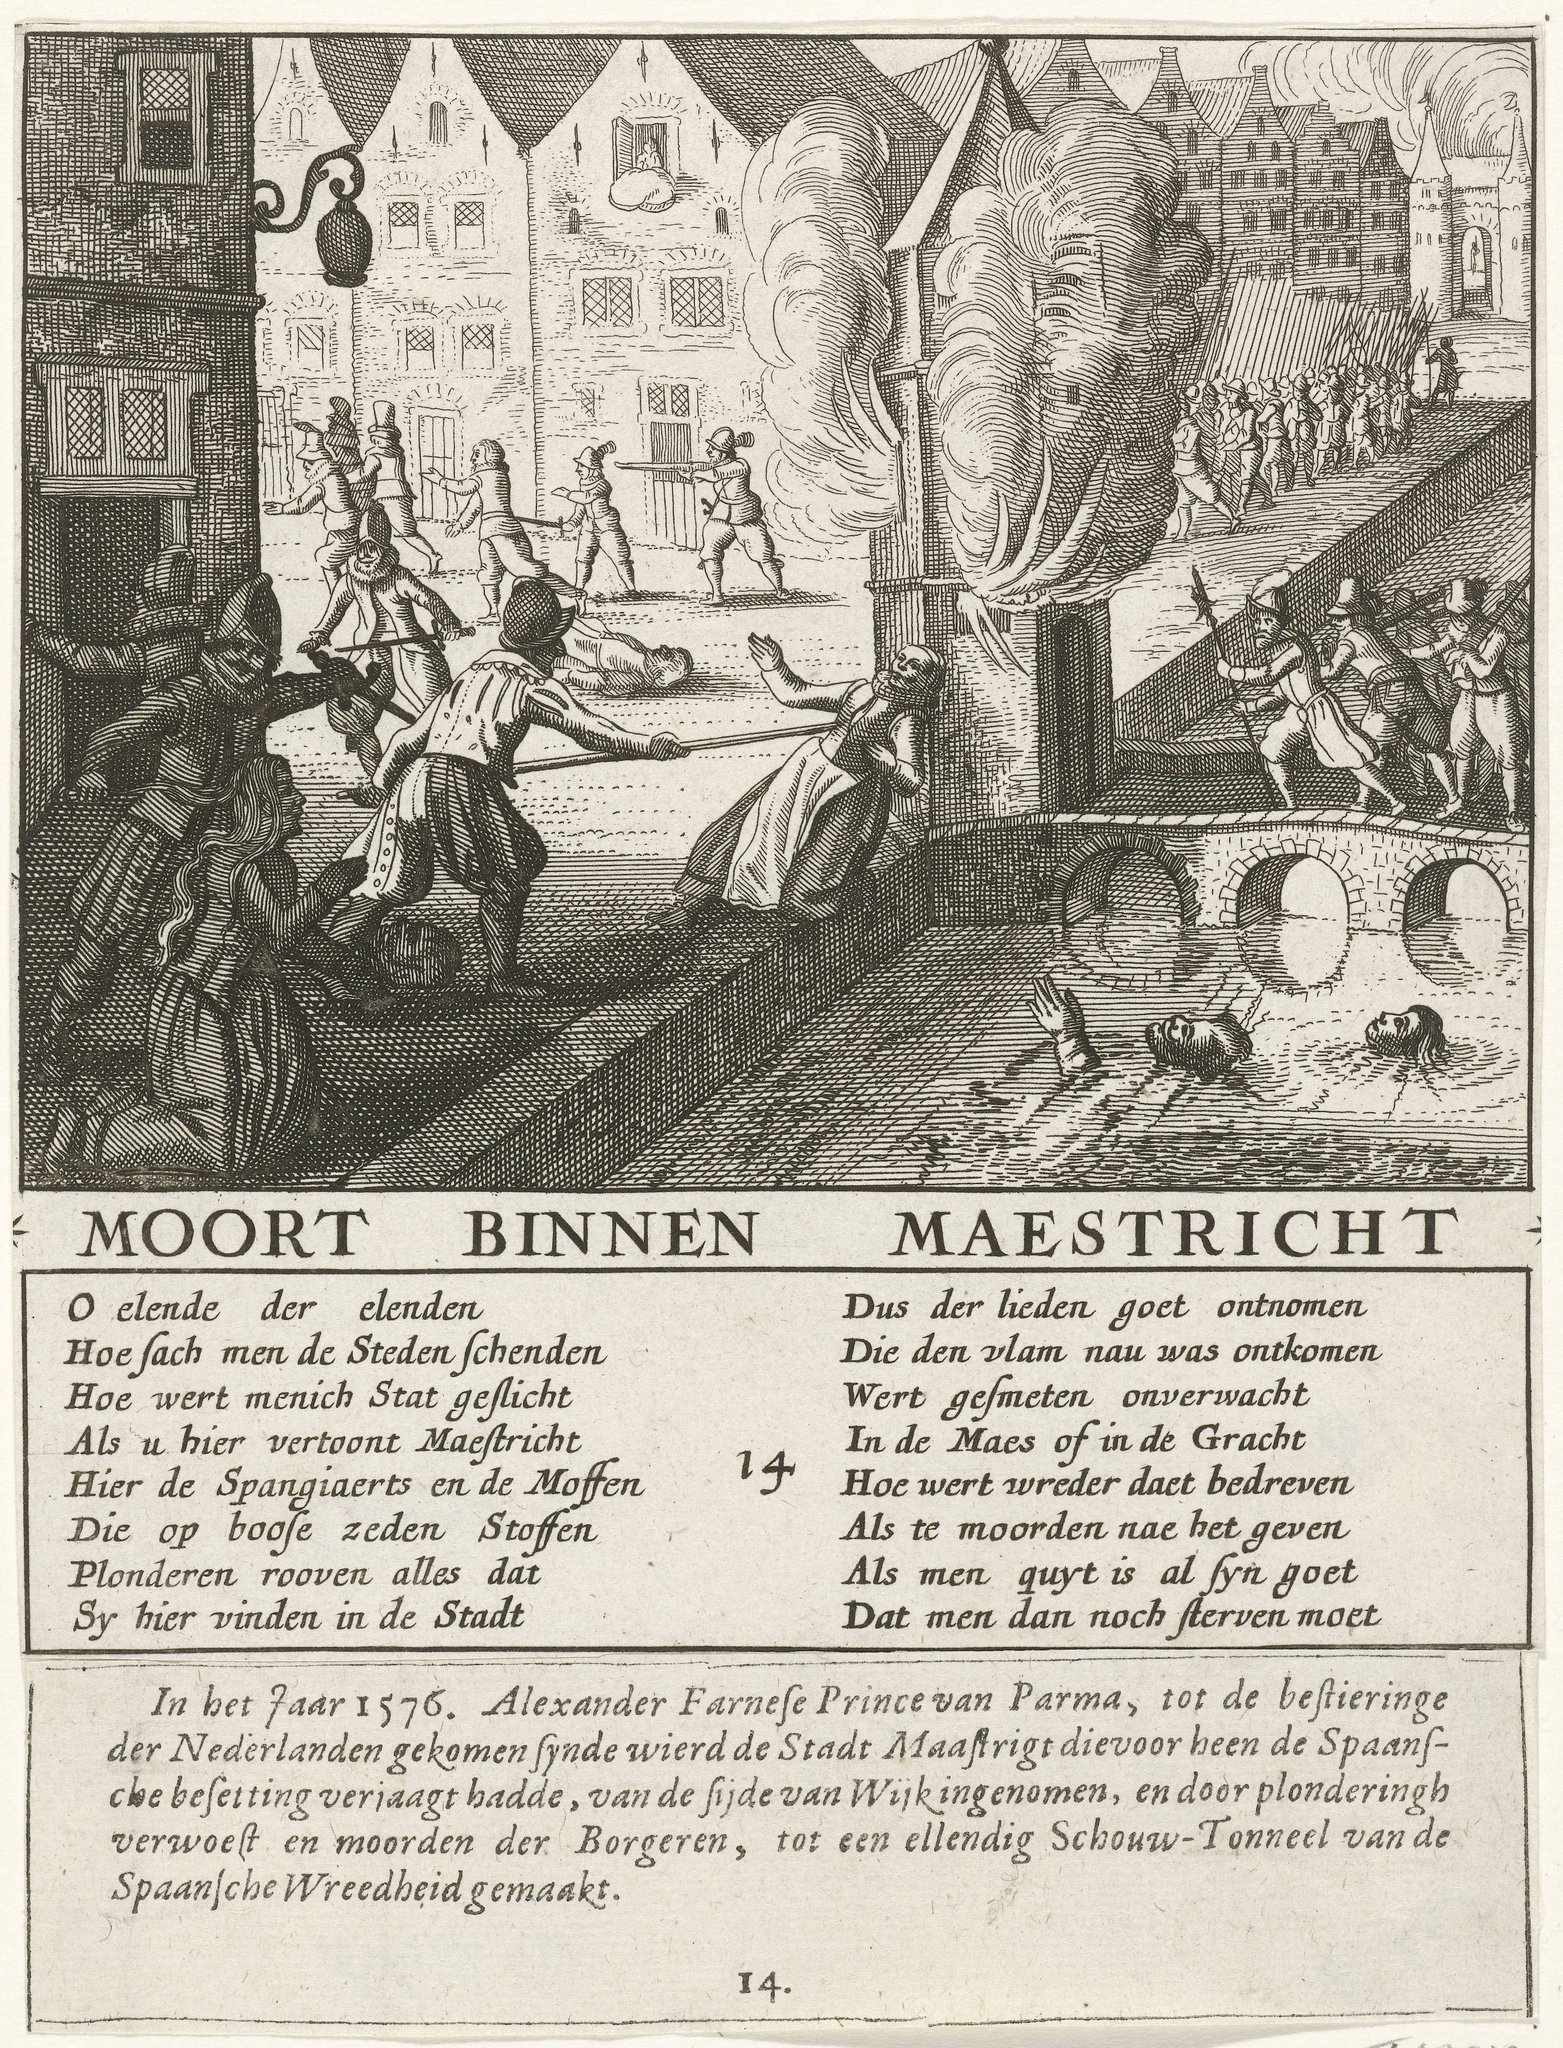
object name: print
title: Moort binnen Maestricht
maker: Anonymous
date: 1618-1624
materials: paper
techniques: engraving, etching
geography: northern netherlands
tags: massacre ~ war, maastricht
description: Illustratie voor een (onbekende) uitgave van het populaire en vaak herdrukte werk getiteld: De Spaensche Tiranye gheschiet in Nederlant, waarschijnlijk voor het eerst ca. 1620 verschenen. Zie ook Hollstein (Dutch), vol. XXXVIII (Claes Jansz. Visscher II), p. 165, nr. 425 en een andere versie van dit werk uitgegeven in 1621 te Amsterdam bij C.L. vander Plasse, in de collectie van de Rijksmuseum Research Library, signatuur 327 K 30.